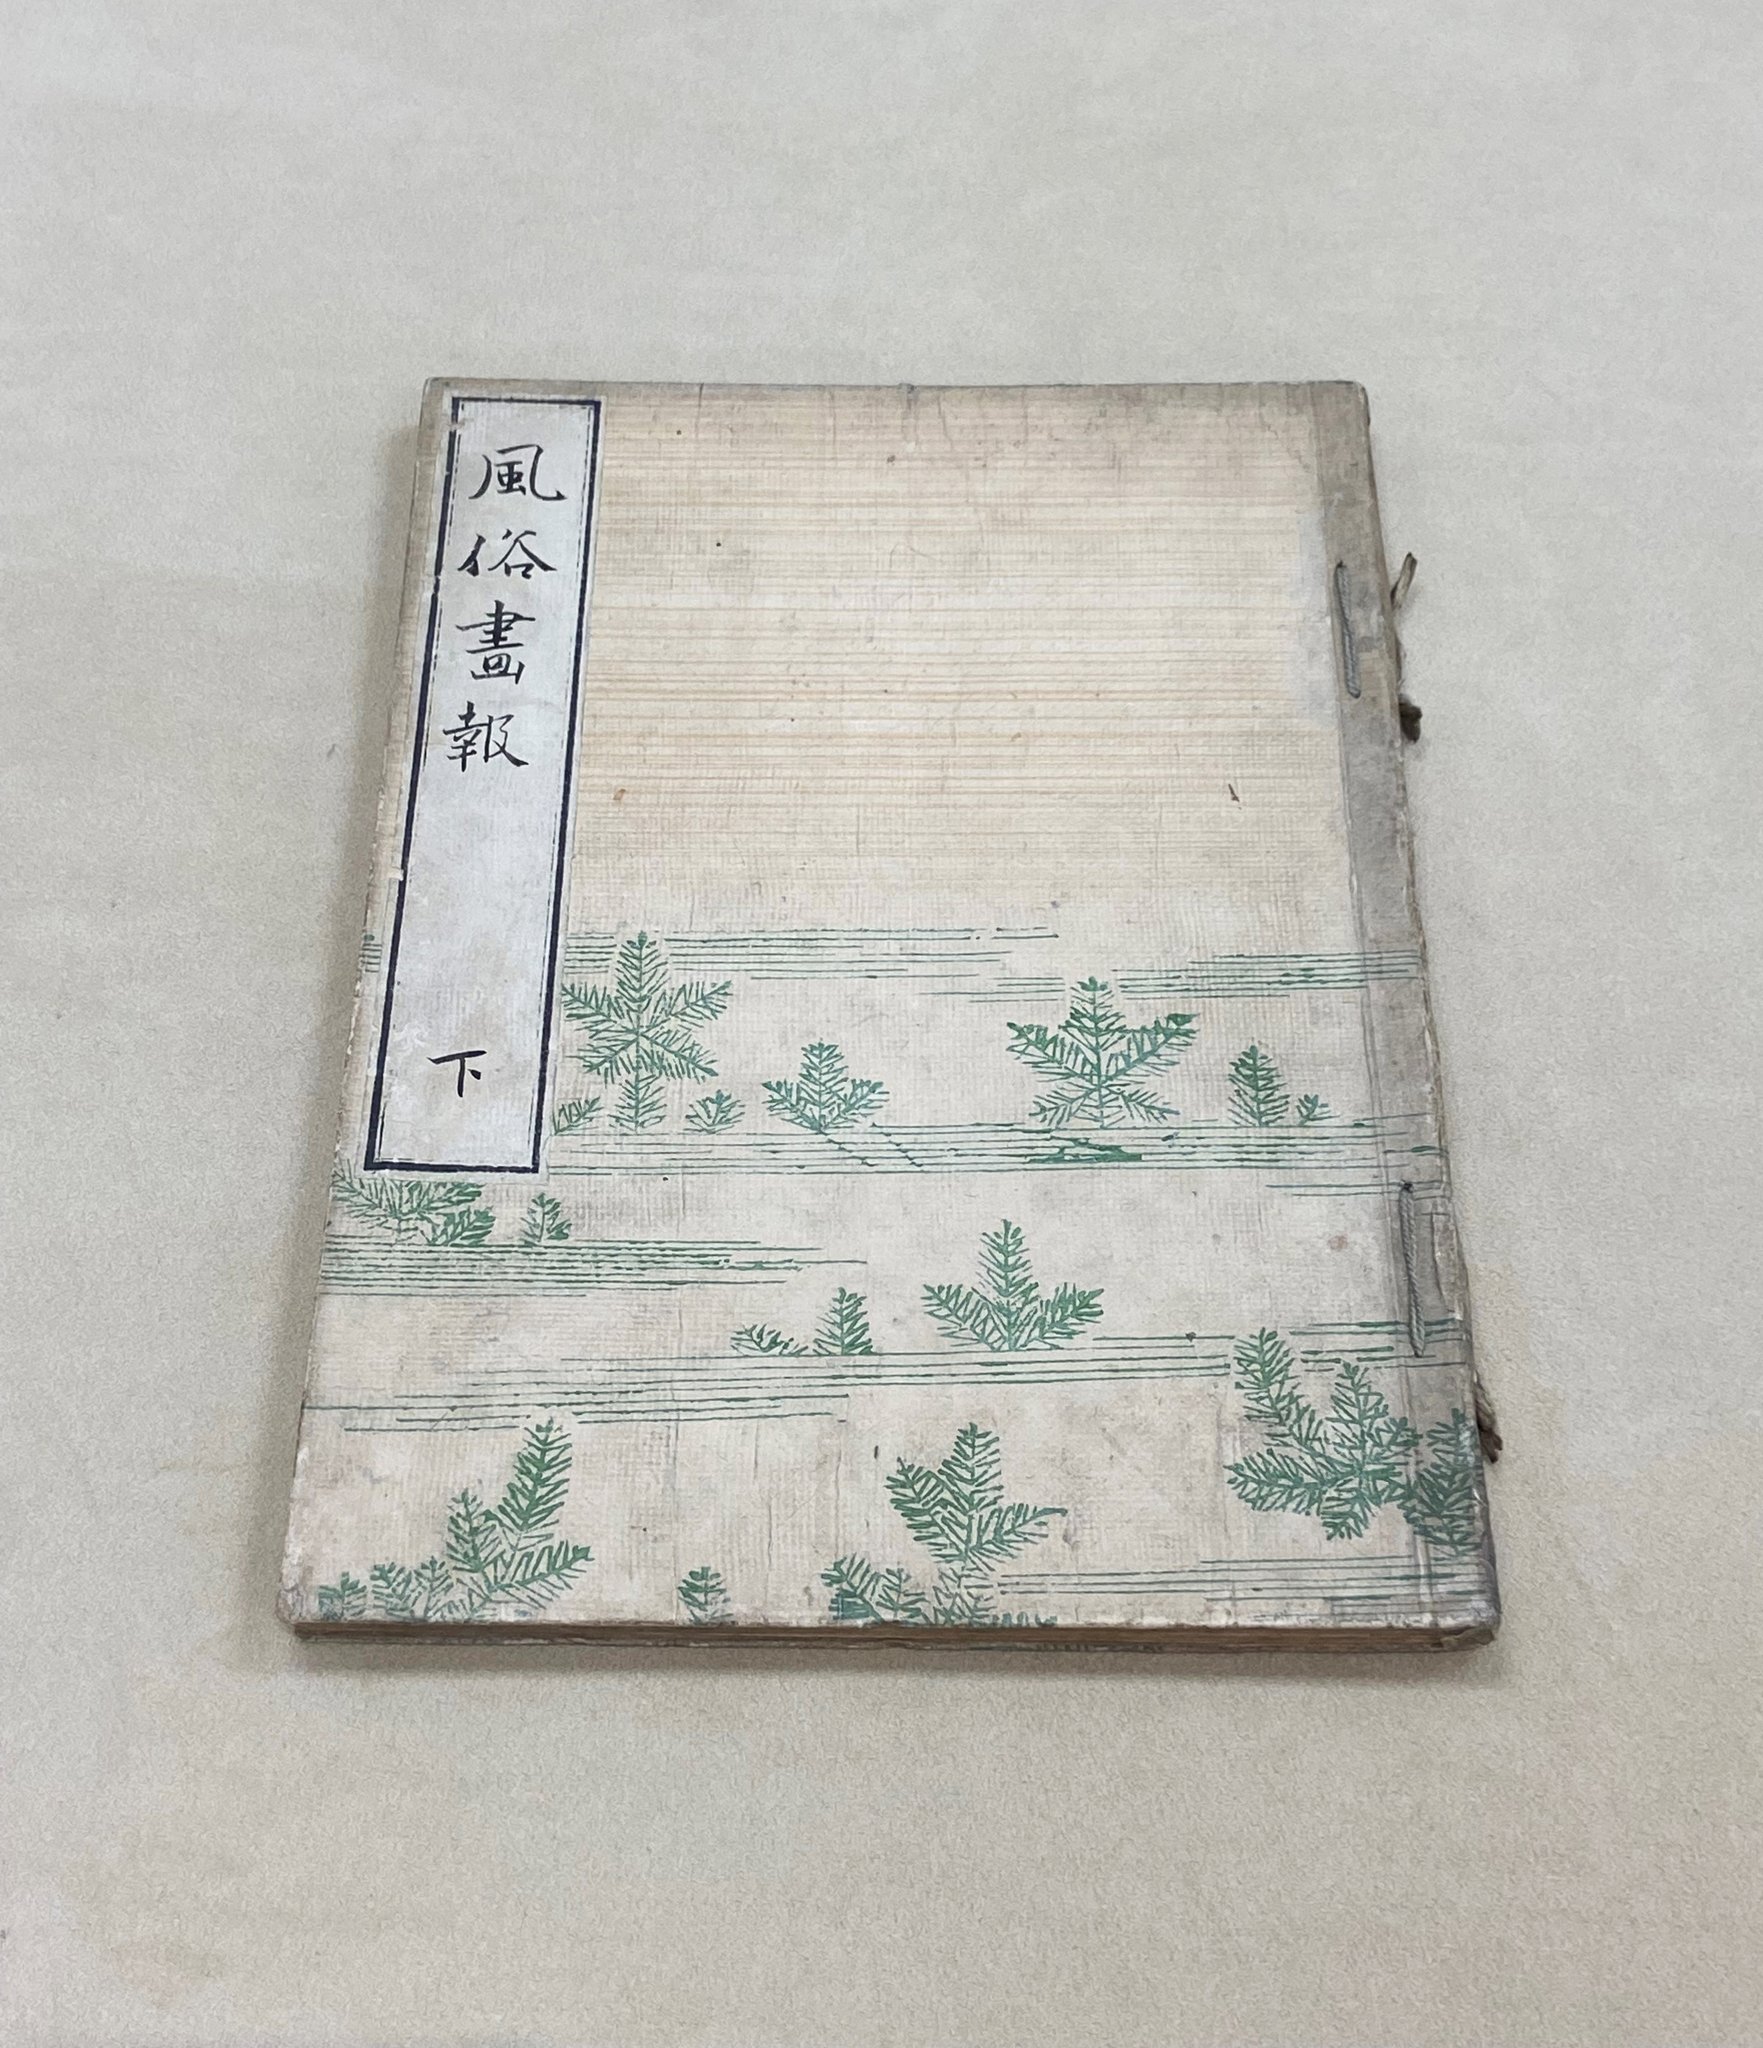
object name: illustrated book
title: Fūzoku gahō (Illustrated Customs) Vol. 1 (issues 1–10)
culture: japanese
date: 1889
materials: ink, paper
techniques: woodblock print